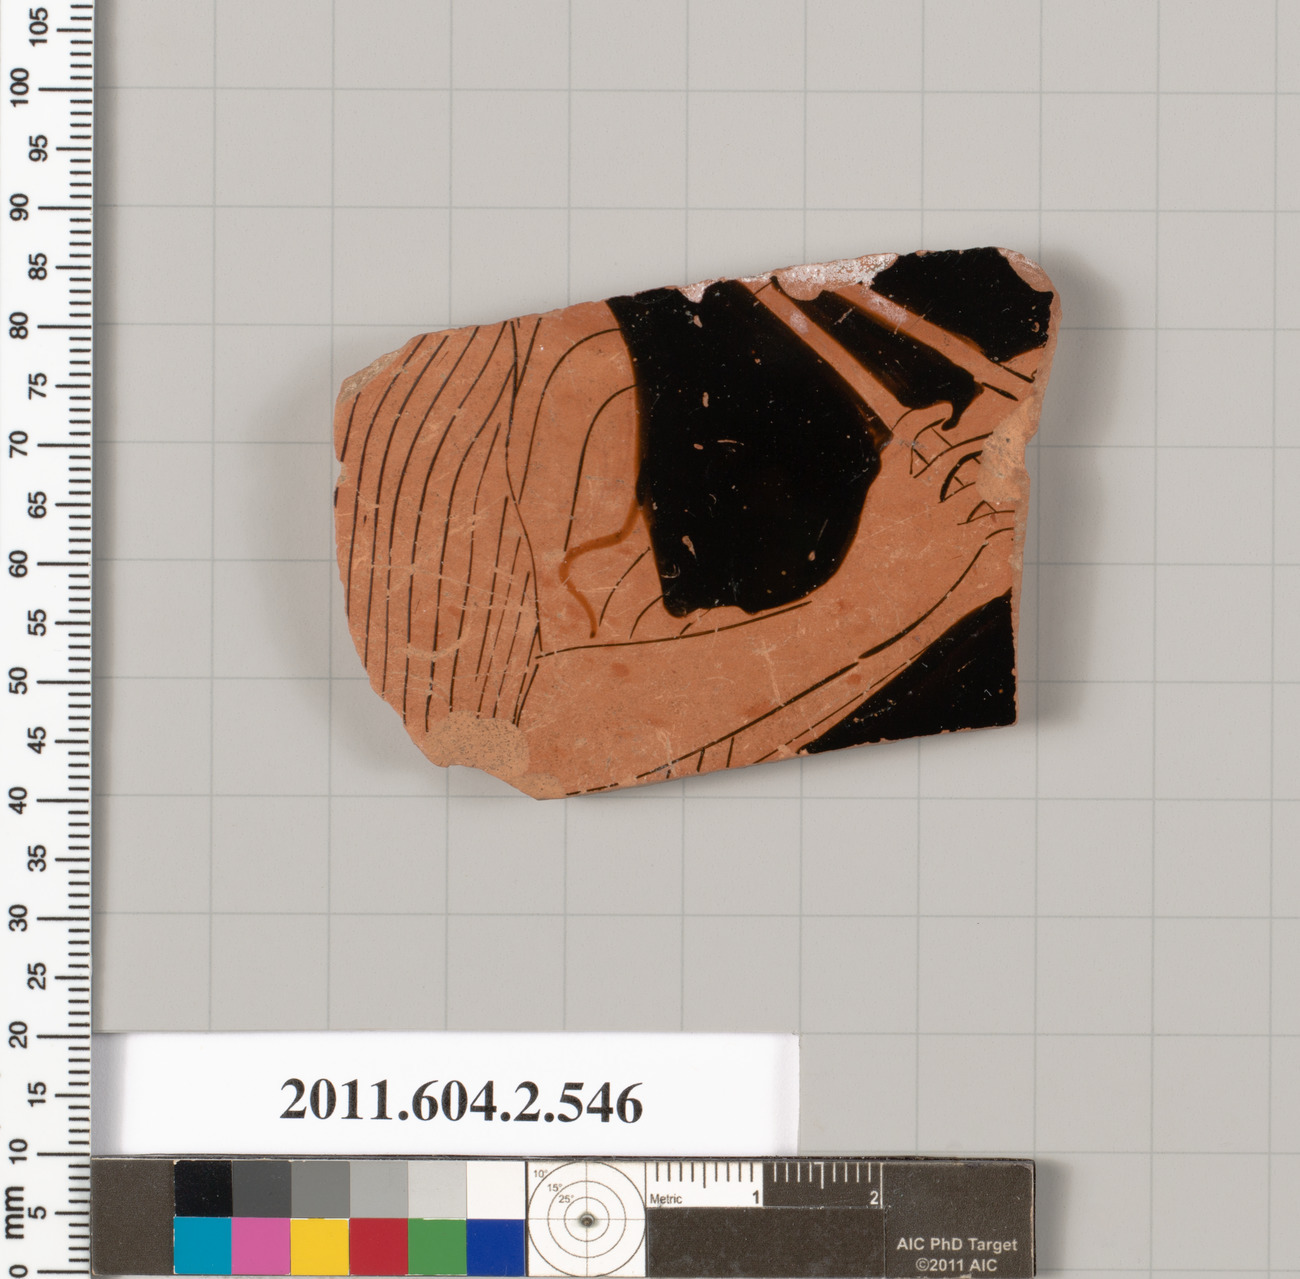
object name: column krater fragment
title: Terracotta fragment of a column-krater (bowl for mixing wine and water)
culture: greek, attic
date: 460-450 BCE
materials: terracotta